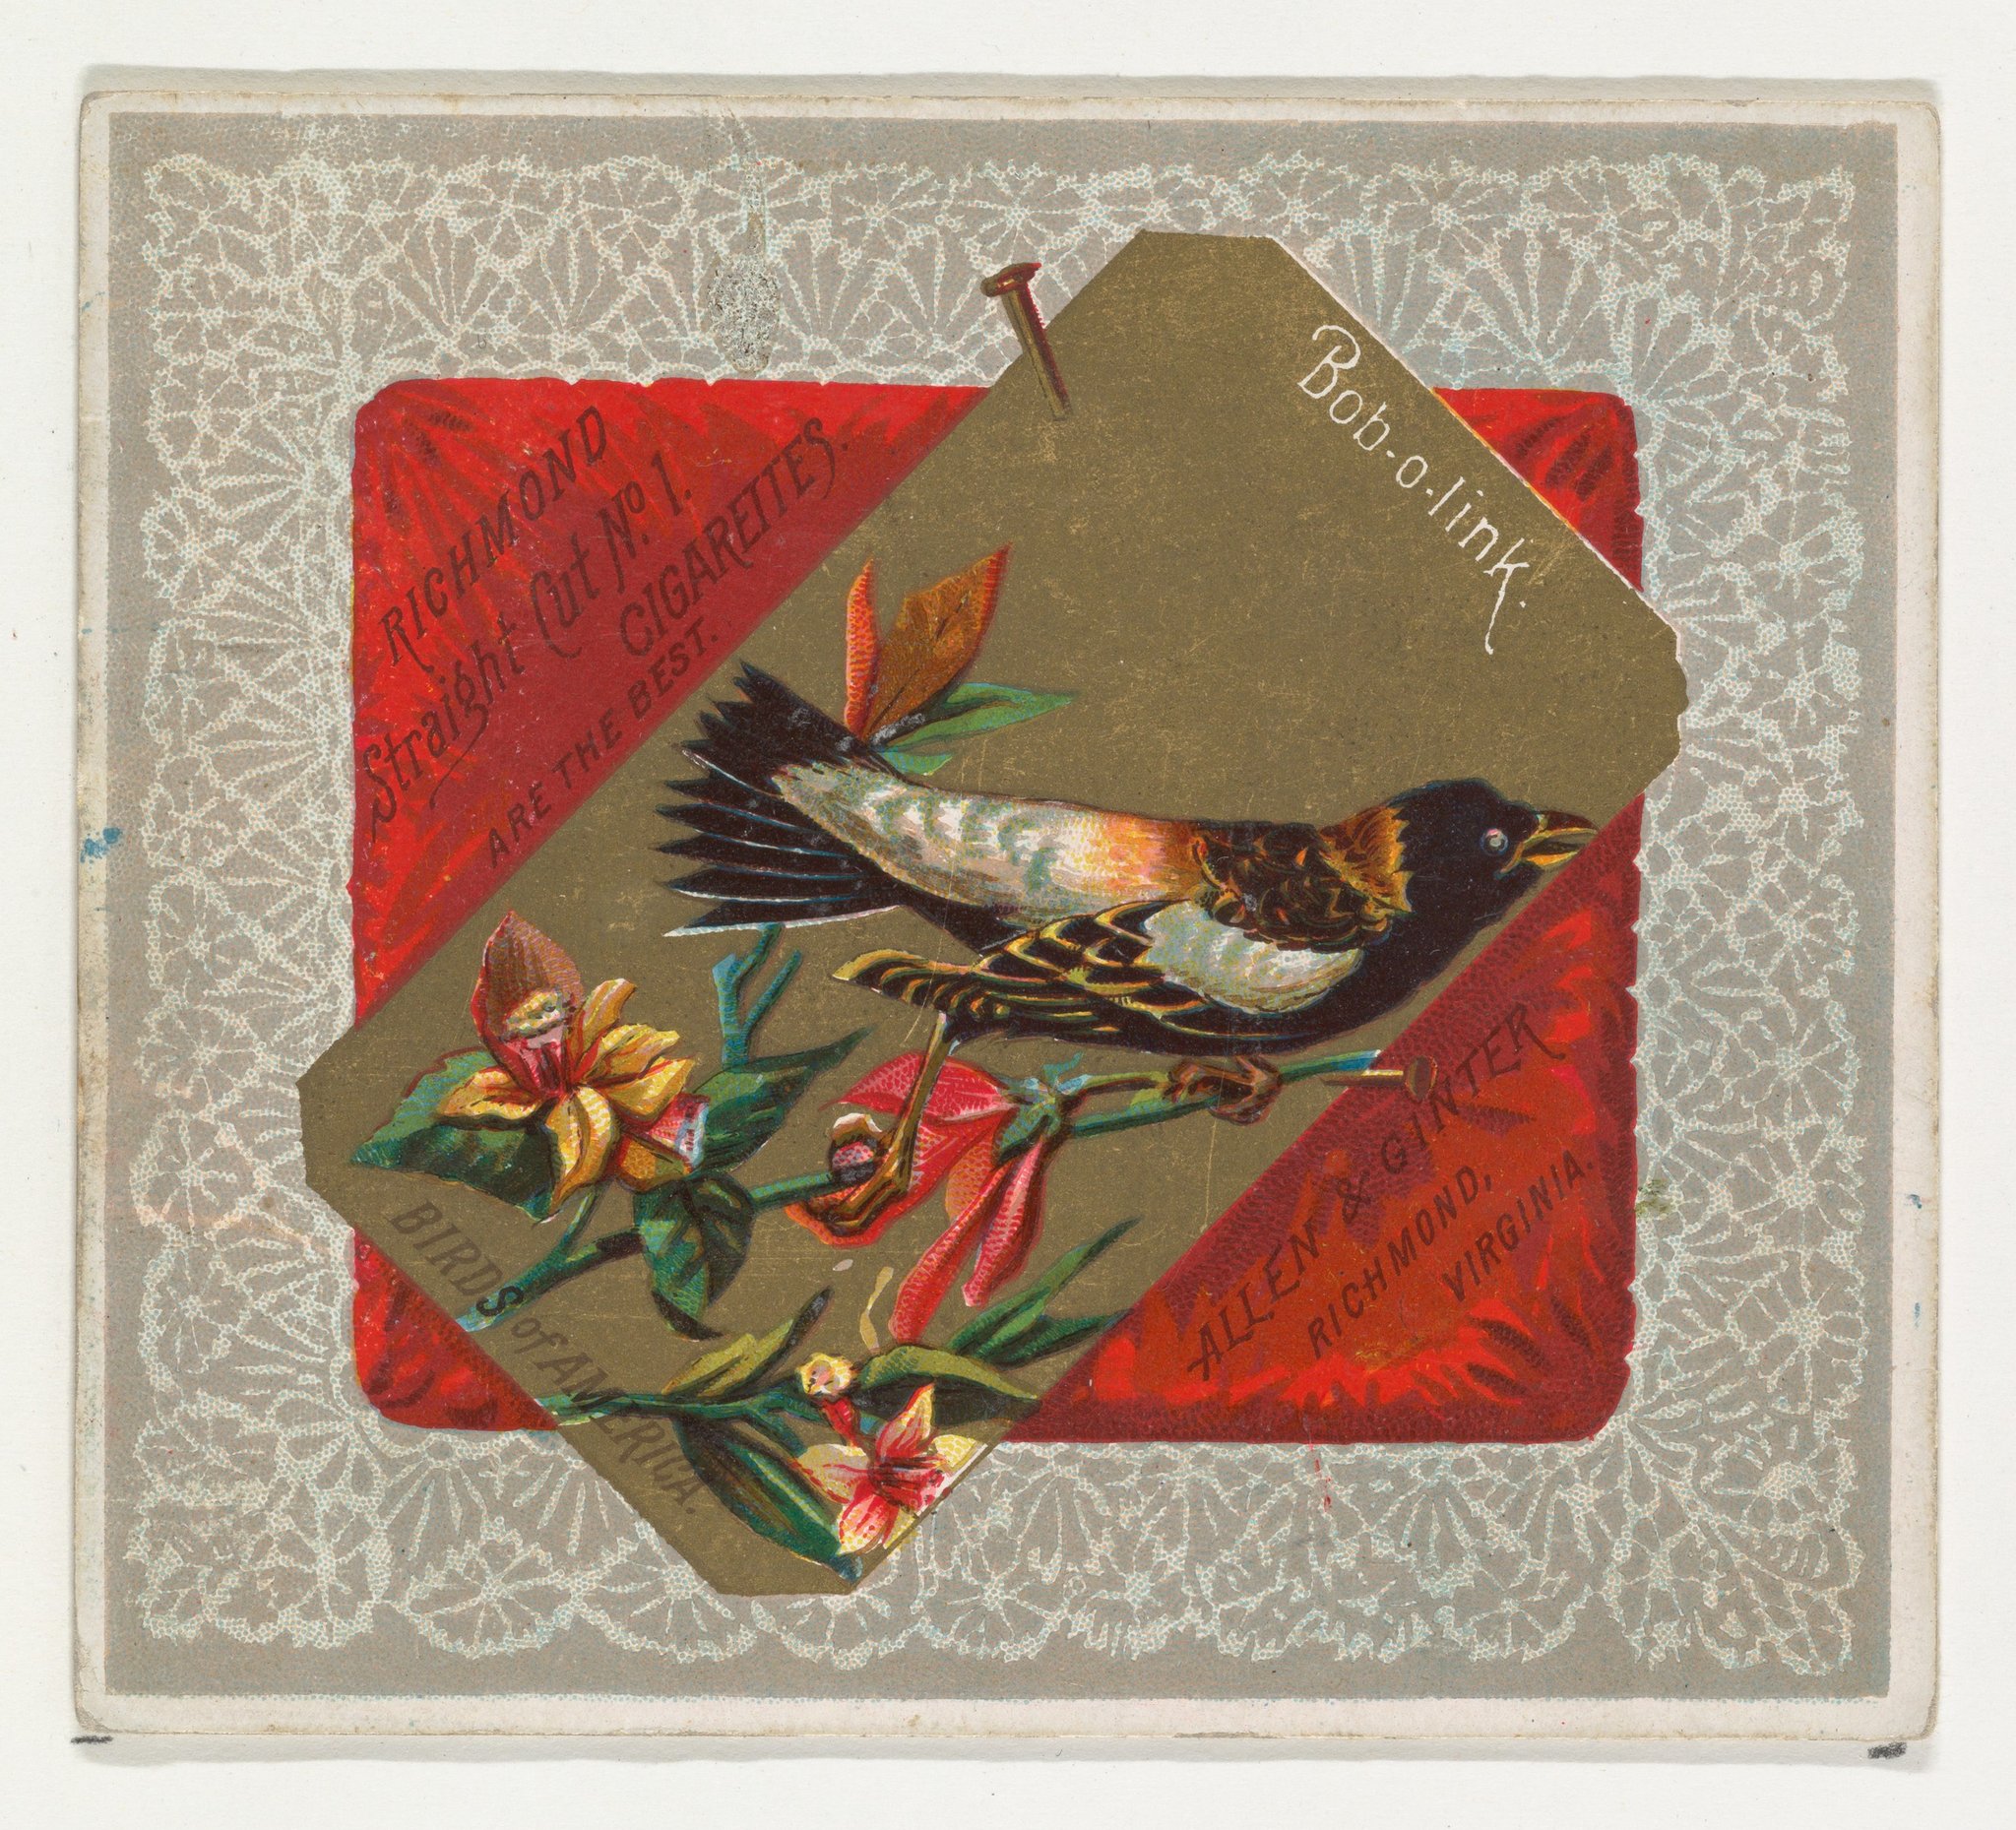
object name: print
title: Bob-o-link, from the Birds of America series (N37) for Allen & Ginter Cigarettes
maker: allen & ginter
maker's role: publisher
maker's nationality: american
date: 1888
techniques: color lithograph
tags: birds,flowers